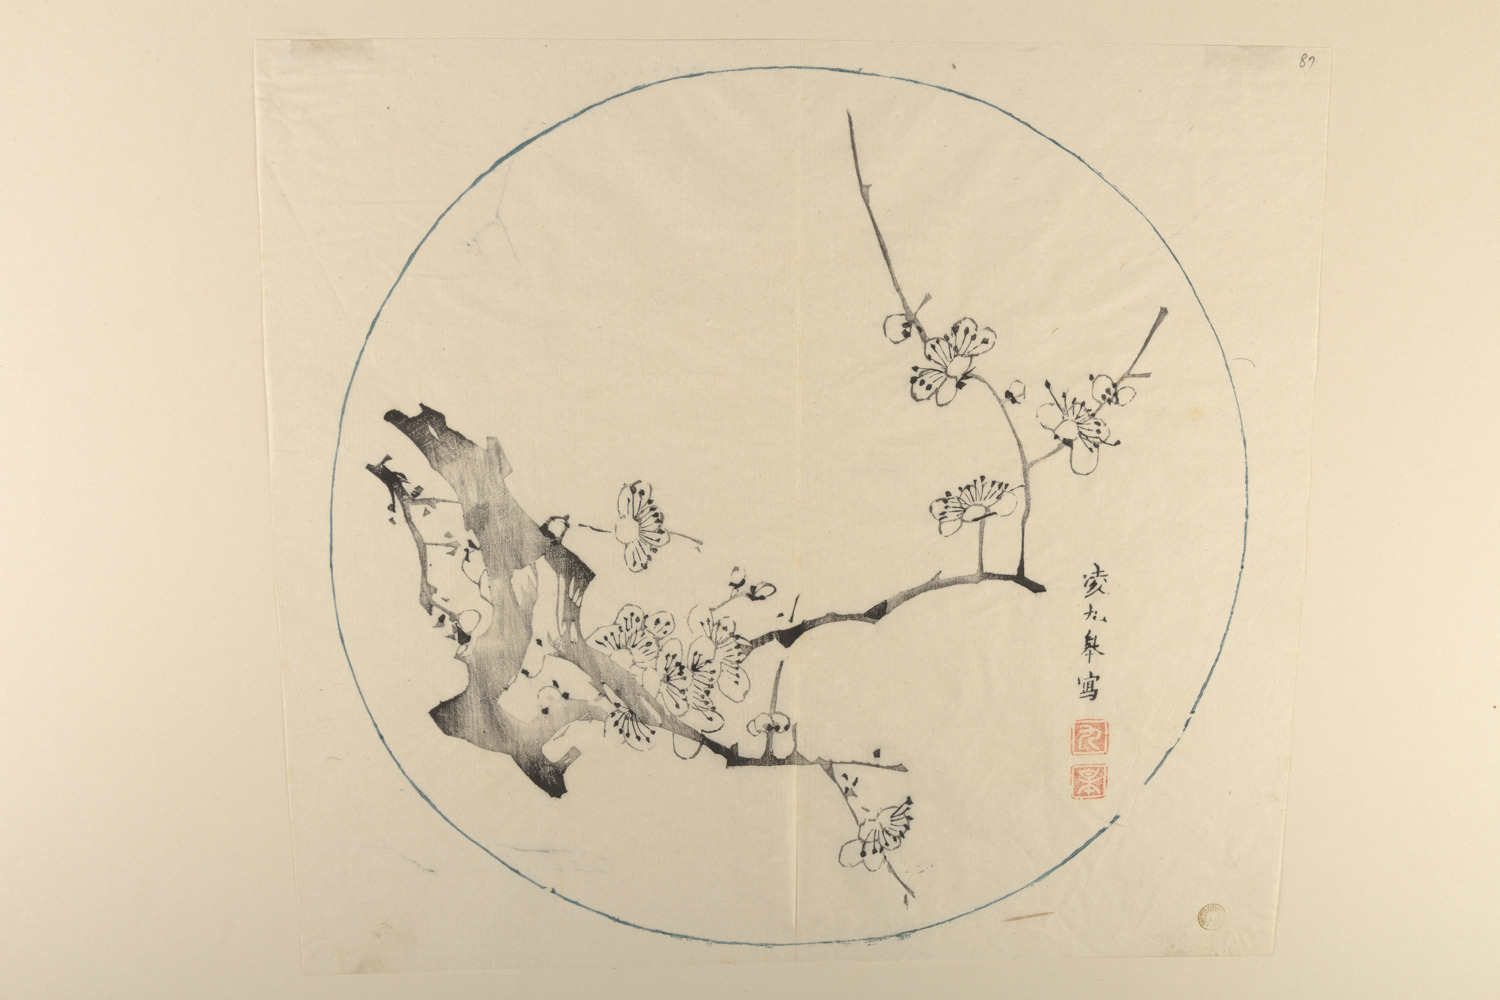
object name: print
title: Page from Shi Zhu Zhai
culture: chinese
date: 1736-1795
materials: ink, paper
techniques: polychrome, woodblock print